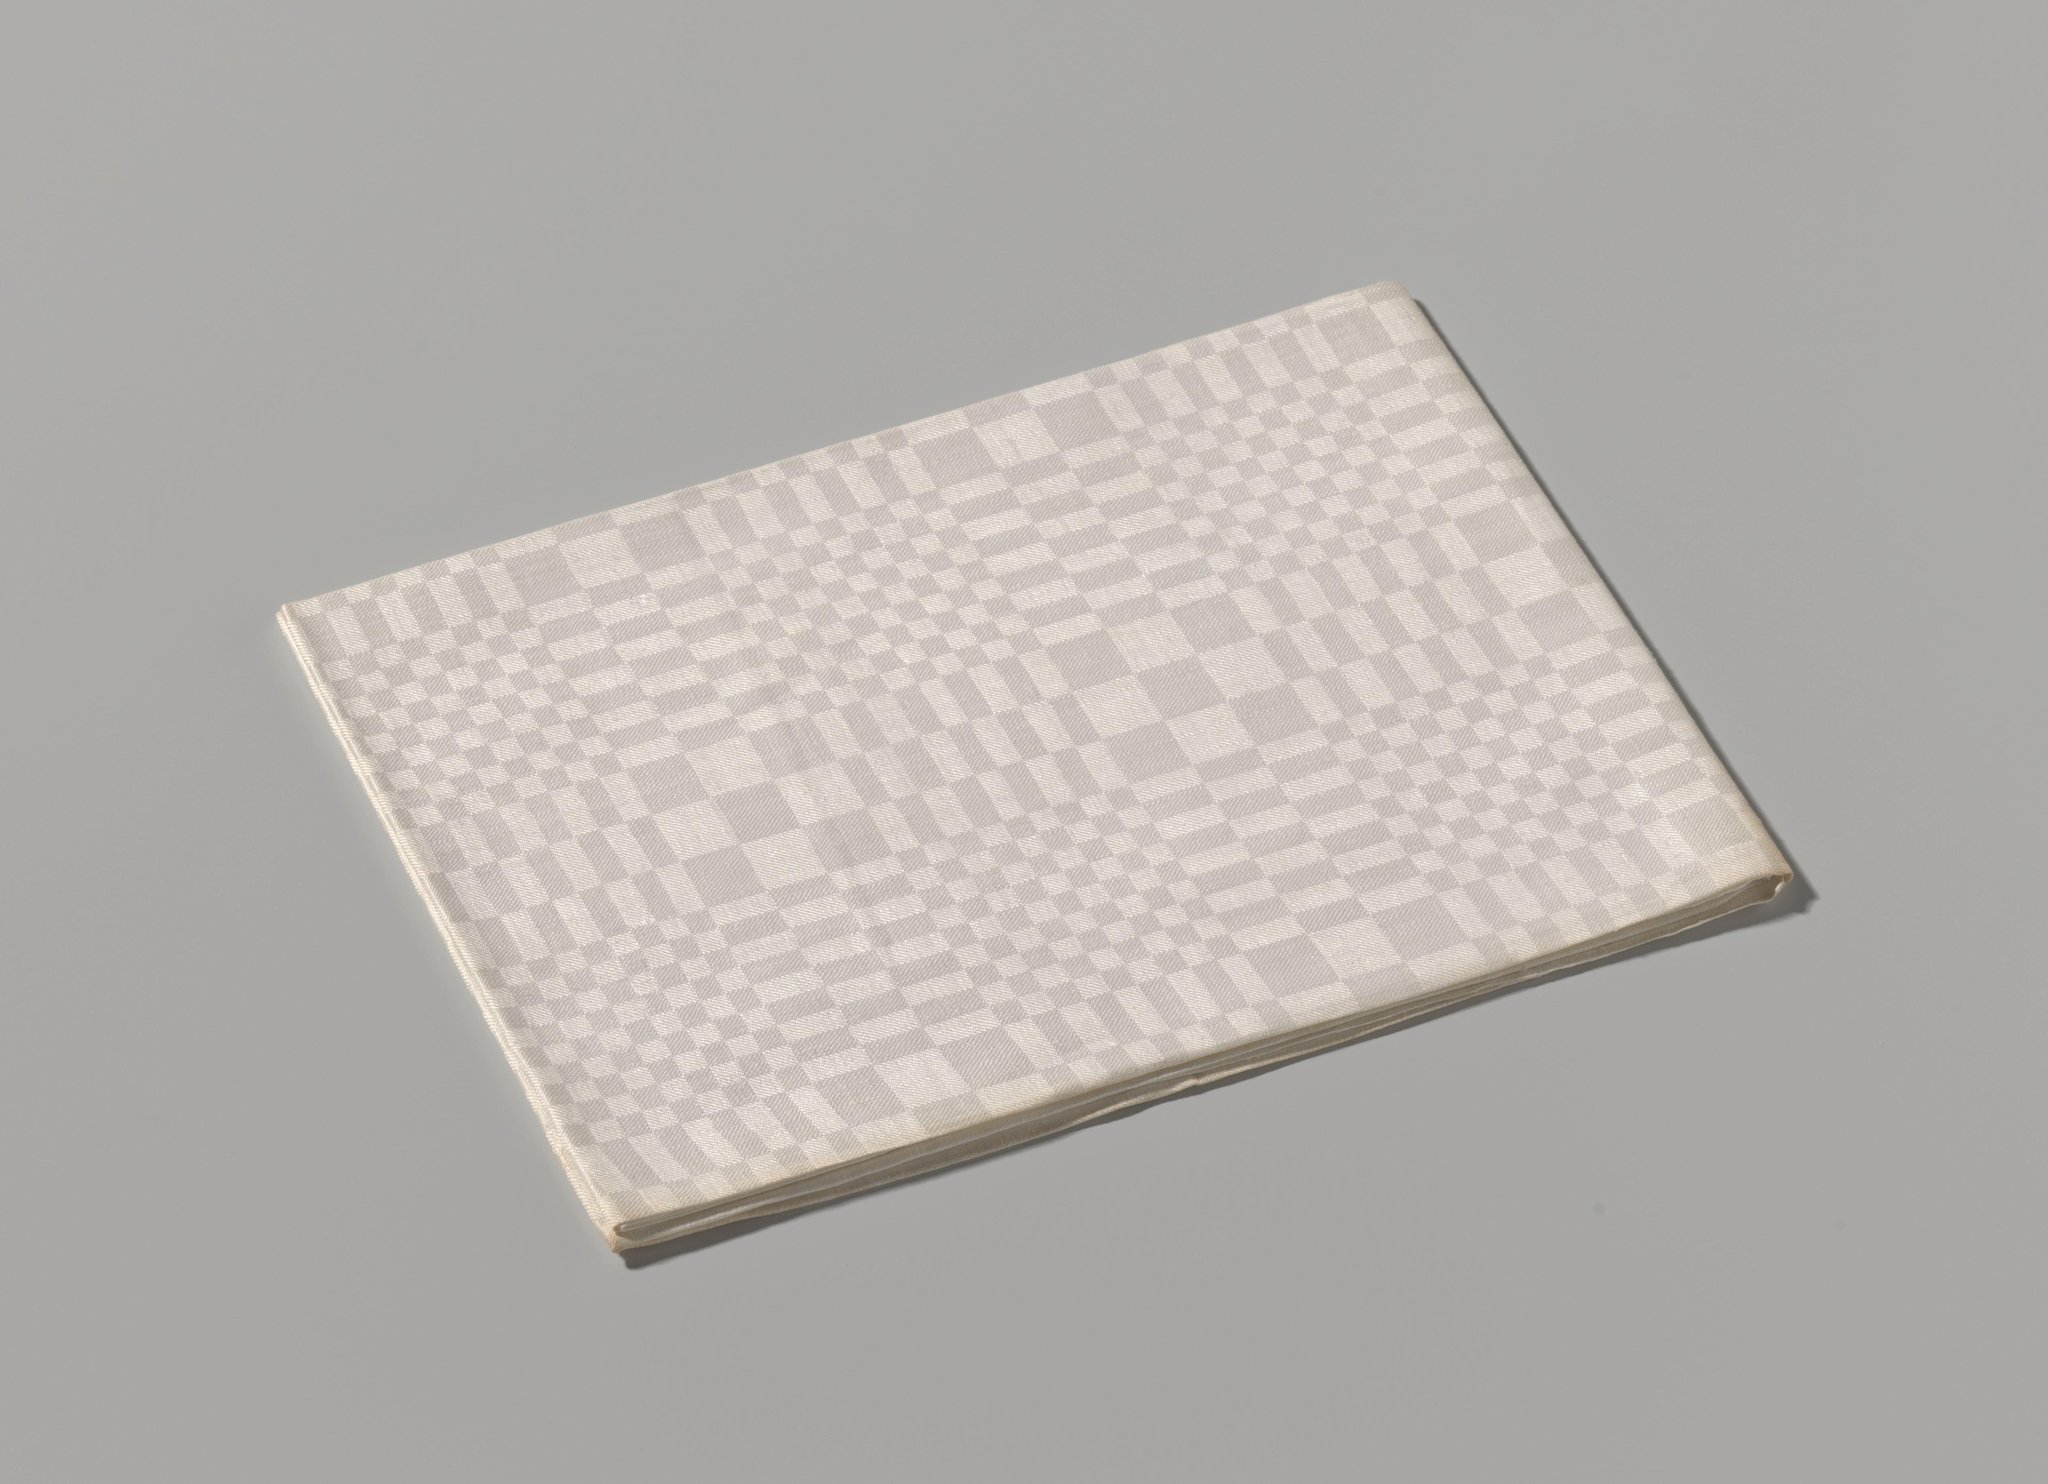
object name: napkin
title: Servet van pellendamast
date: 1739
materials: linen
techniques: weave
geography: northern netherlands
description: Wit linnen servet met pellenpatroon, genaamd "Engelse garderobe". Merk kroon WG 36 1739.